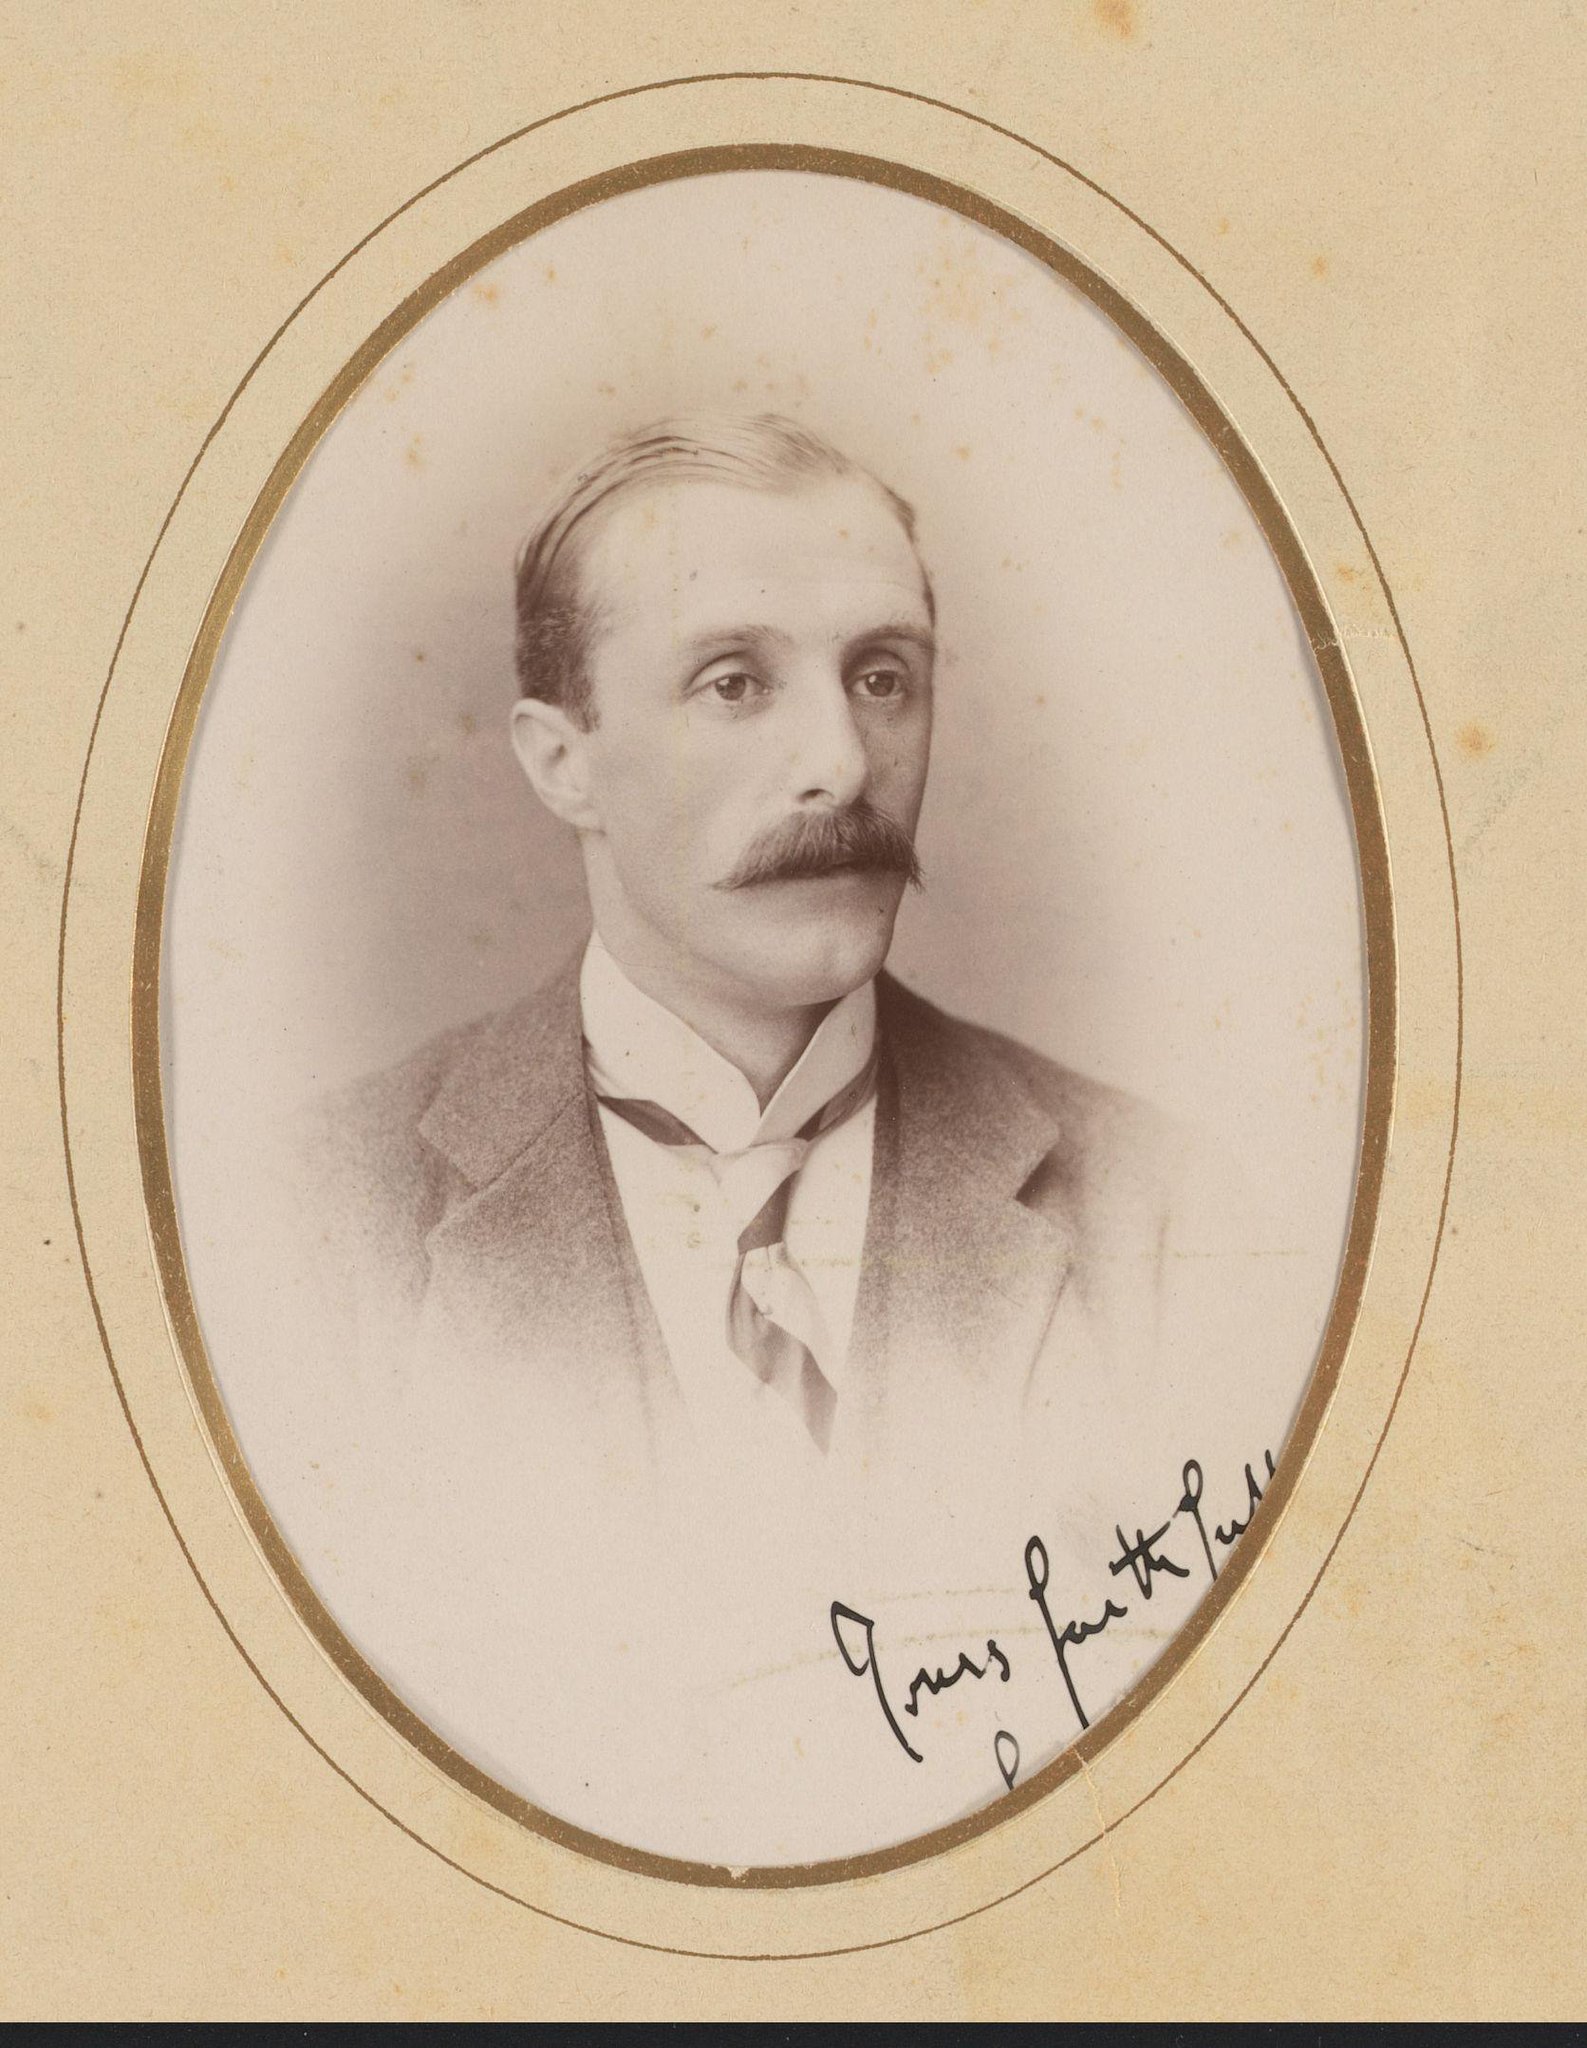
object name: album leaf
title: Portret van een man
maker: charles edmund long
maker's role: fotograaf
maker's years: 1856-1904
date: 1895-1904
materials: cardboard, photographic support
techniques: albumen print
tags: moustache, adult man, anonymous historical persons portrayed in a group, in a group-portrait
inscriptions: annotation: ‘Yours faithfully/ Lionel, Holland’, inscription: ‘Chas E. Long 60, Bow Road, E.’